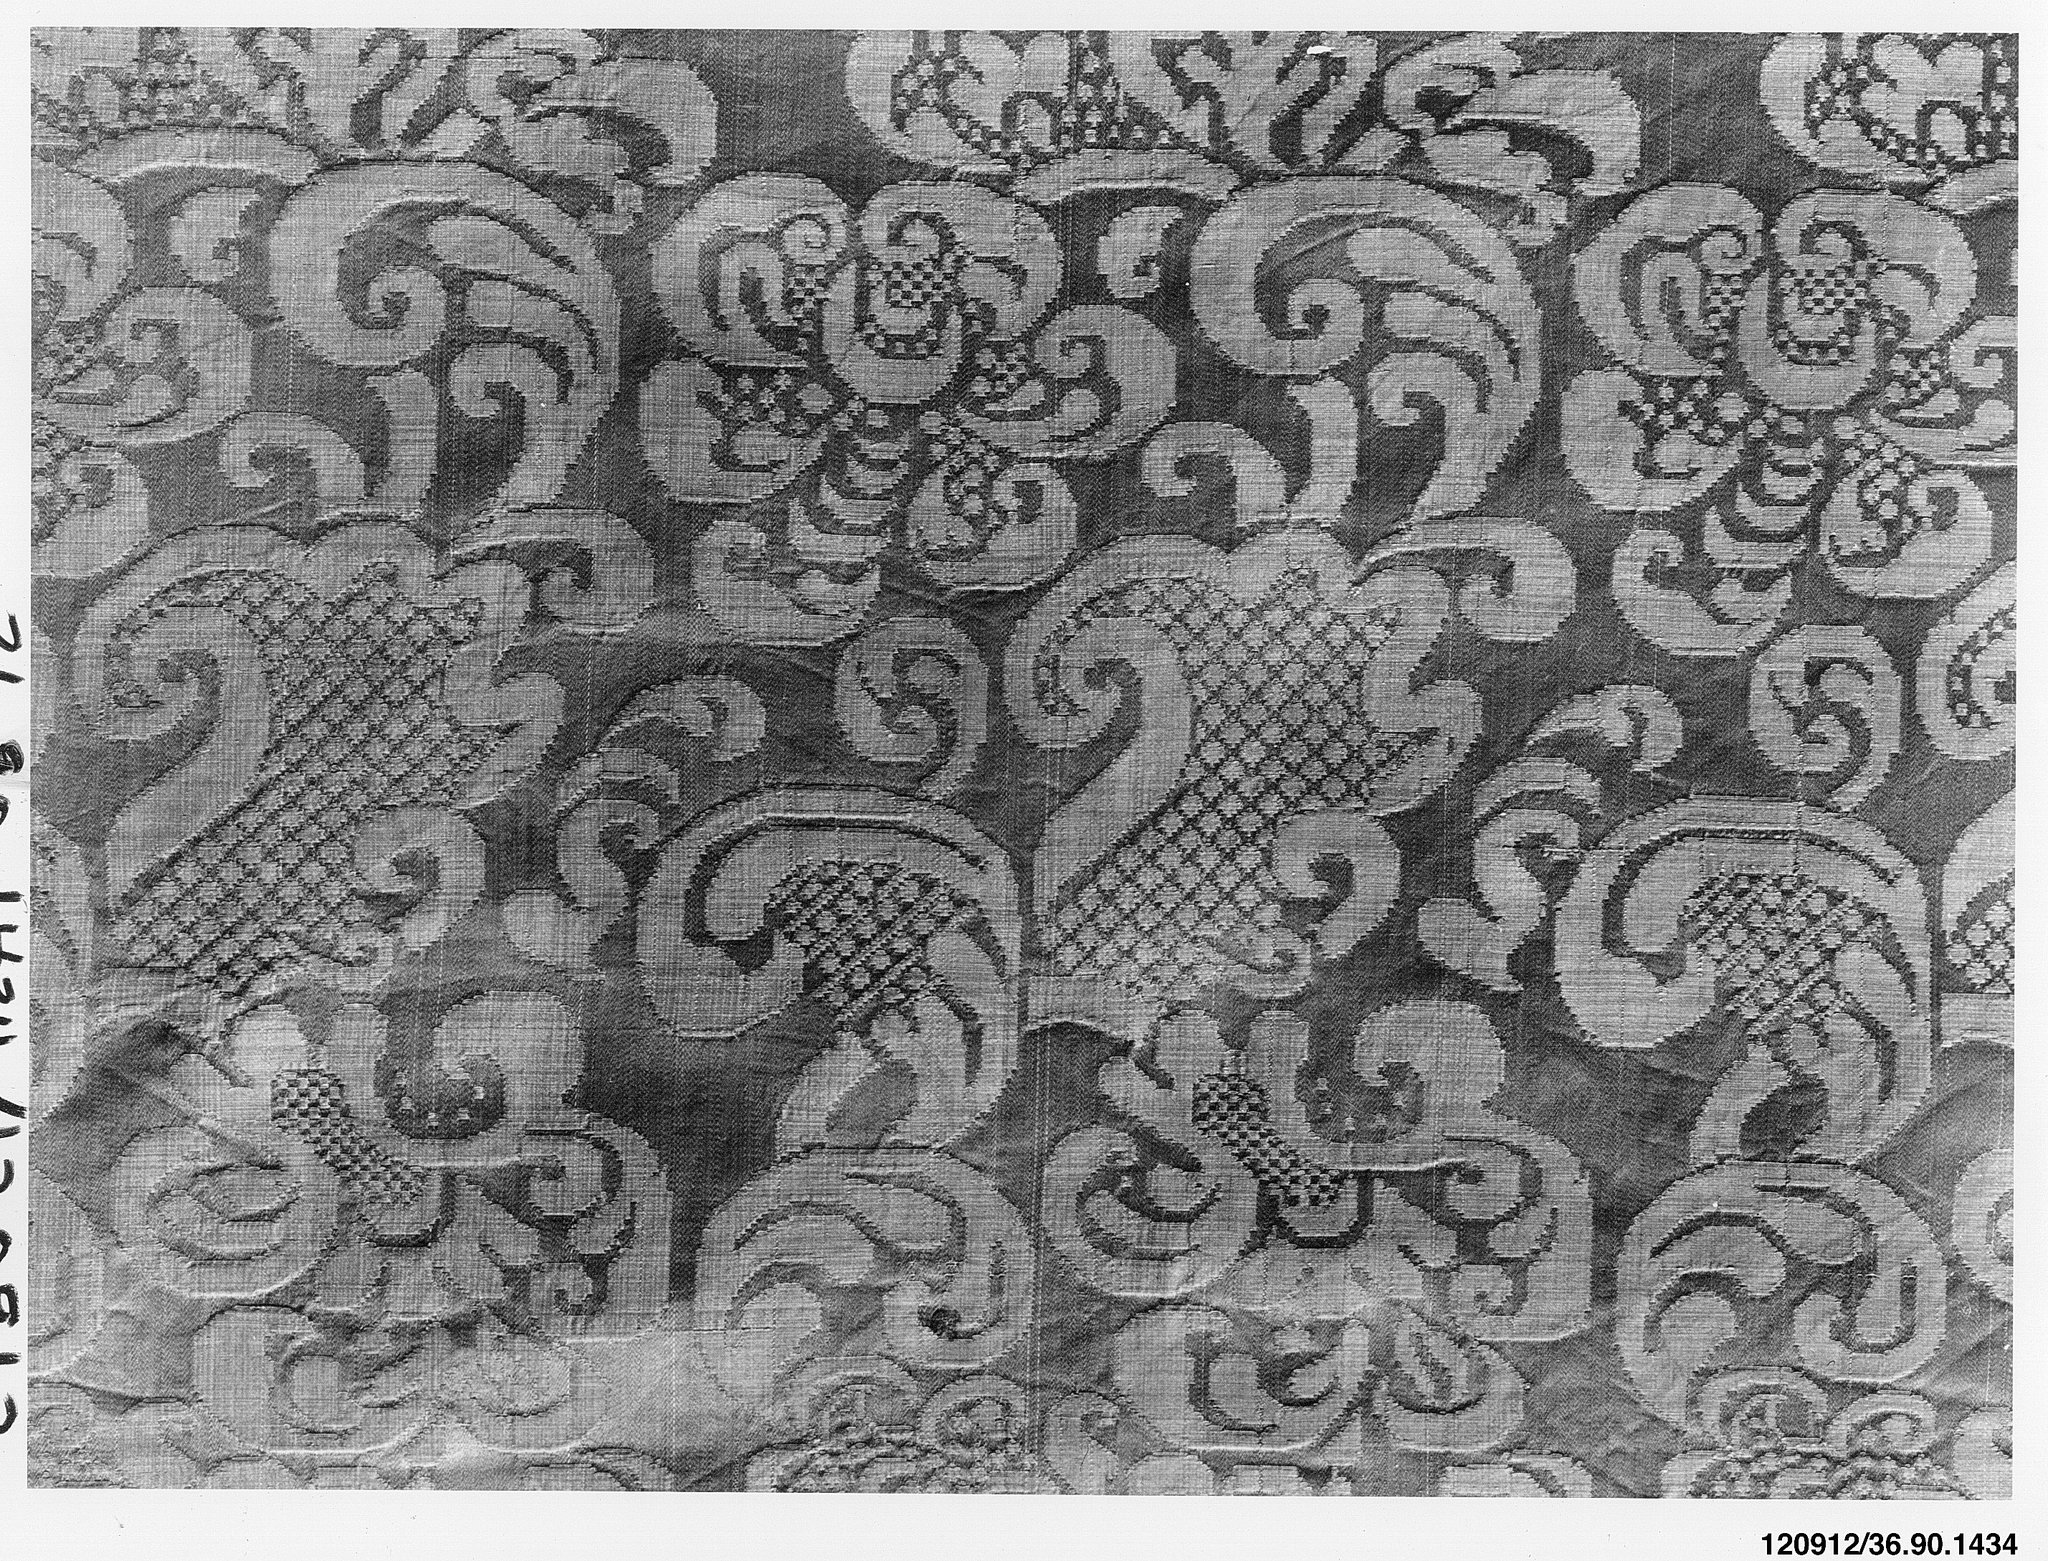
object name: piece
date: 1601-1700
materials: silk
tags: flowers